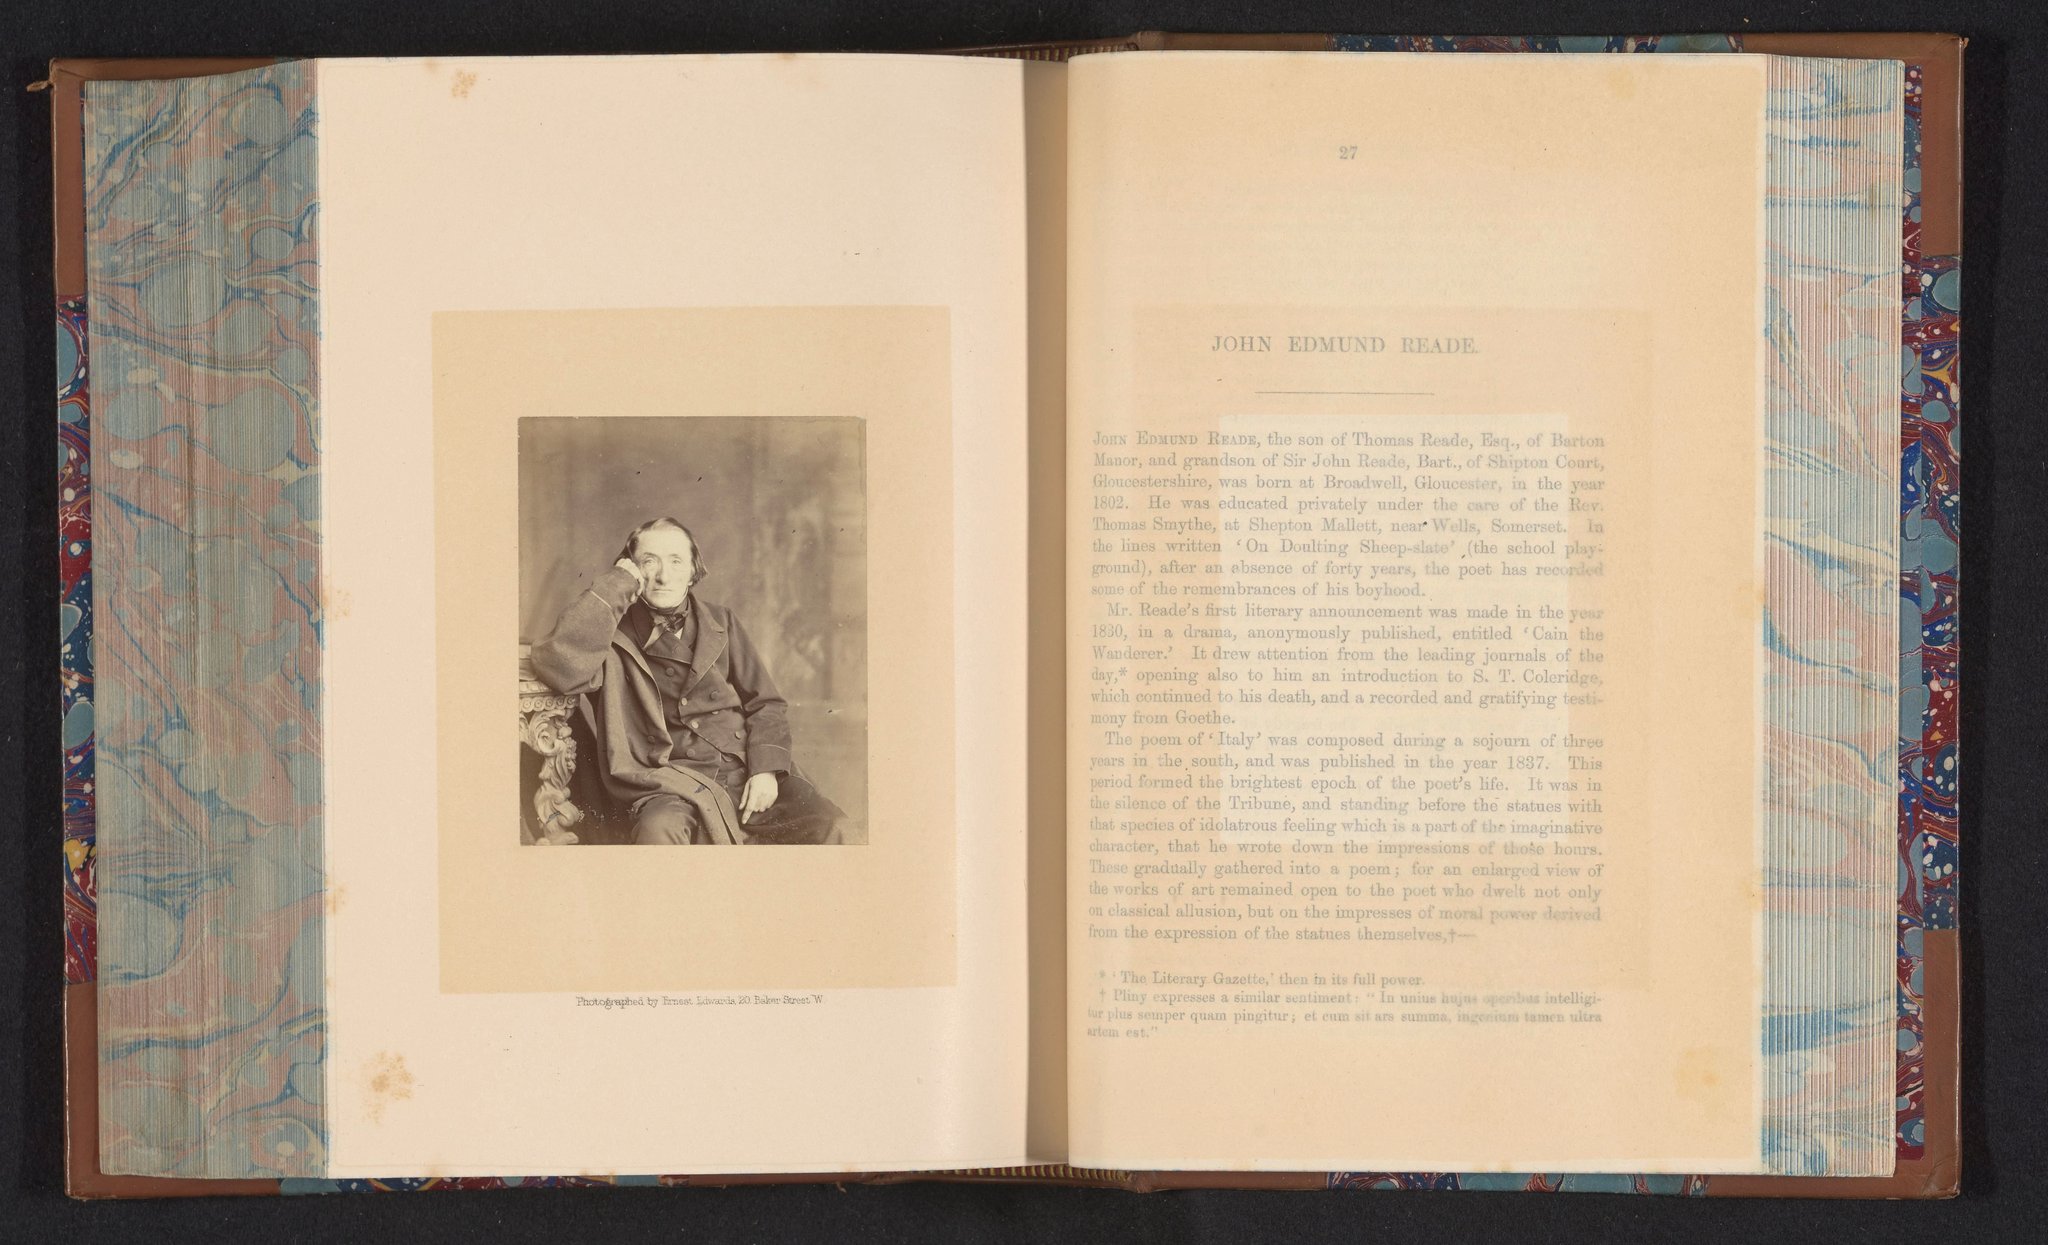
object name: photograph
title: Portret van John Edmund Reade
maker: ernest edwards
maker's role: fotograaf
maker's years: 1837-1903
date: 1853-1867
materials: photographic support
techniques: albumen print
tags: studio requisites ~ photographer, writer, poet, author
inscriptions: name: ‘Photographed by Ernest Edwards, 20, Baker Street. W.’